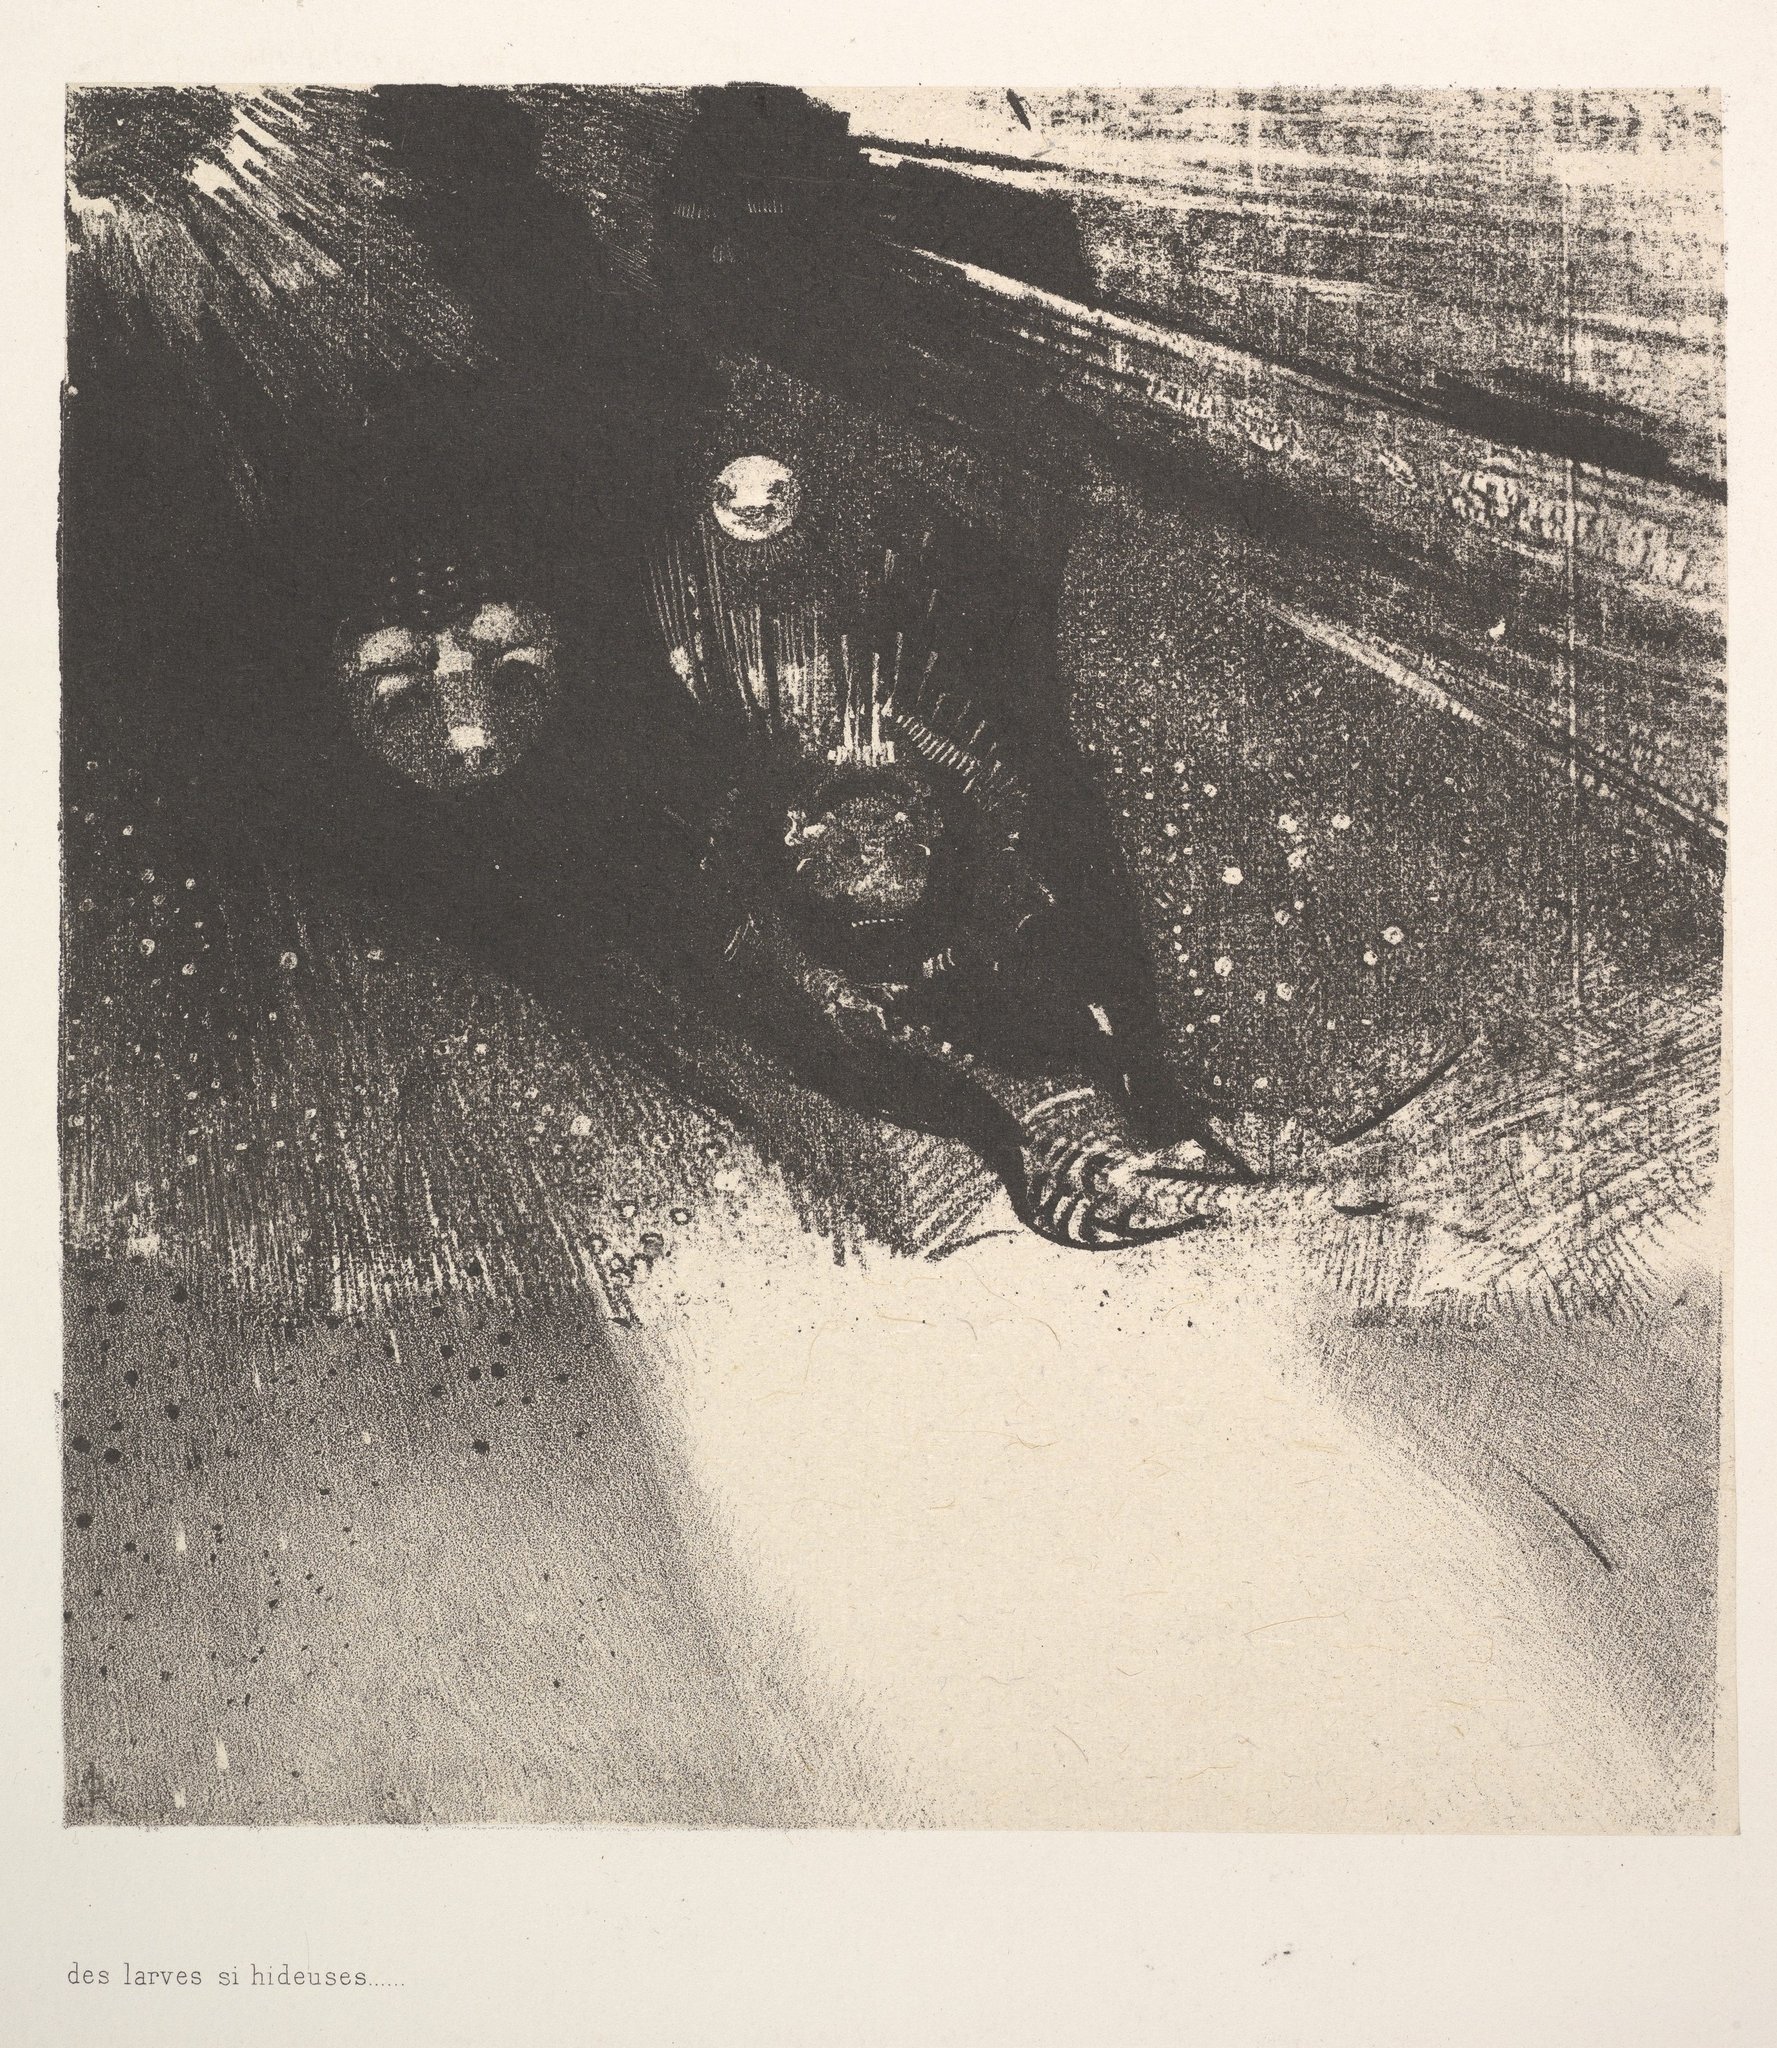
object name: print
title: Hideous Larvae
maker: odilon redon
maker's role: artist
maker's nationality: french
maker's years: 1840-1916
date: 1896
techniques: lithograph